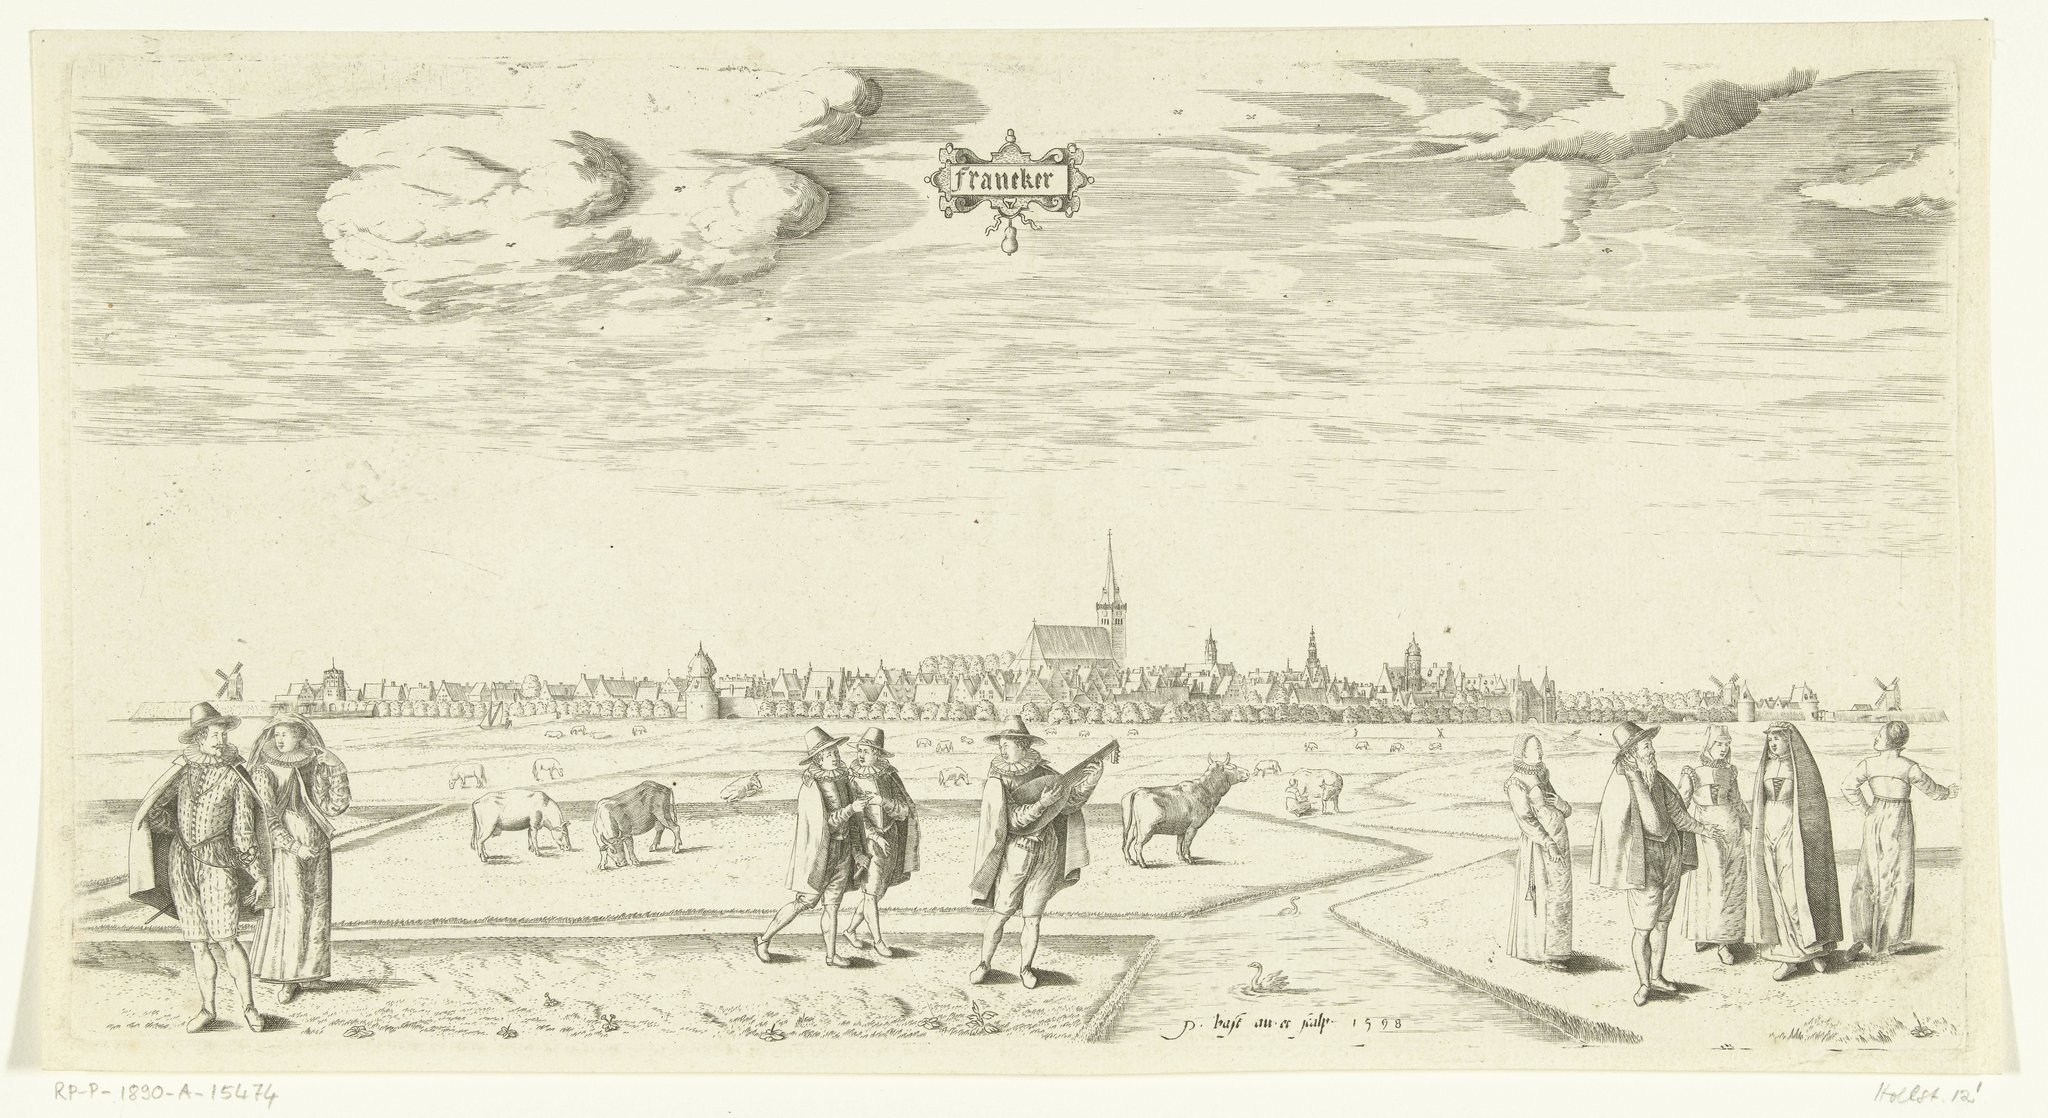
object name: print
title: Gezicht op Franeker 1598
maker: pieter bast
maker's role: print maker, publisher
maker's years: 1570-1605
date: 1598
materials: paper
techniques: engraving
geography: northern netherlands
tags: cattle, cape (huik) (+ women's clothes), clothes, costume (+ women's clothes), clothes, costume (+ men's clothes), one person playing string instrument (plucked), lute, and special forms of lute, e.g.: theorbo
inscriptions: collector's mark: Lugt 2228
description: Op de voorgrond verschillende wandelende en pratende burgers, gekleed volgens de mode van ca. 1600. Linksvoor een man en vrouw met een sluier over het hoofd. In het midden een muzikant die de luit bespeelt en twee lopende jongemannen. Rechts een groepje van drie vrouwen en een man en een boerenvrouw op de rug gezien. Koeien in de wei. Franeker met in het midden de grote kerk in het verschiet. Middenboven cartouche waarin de naam: Franeker.